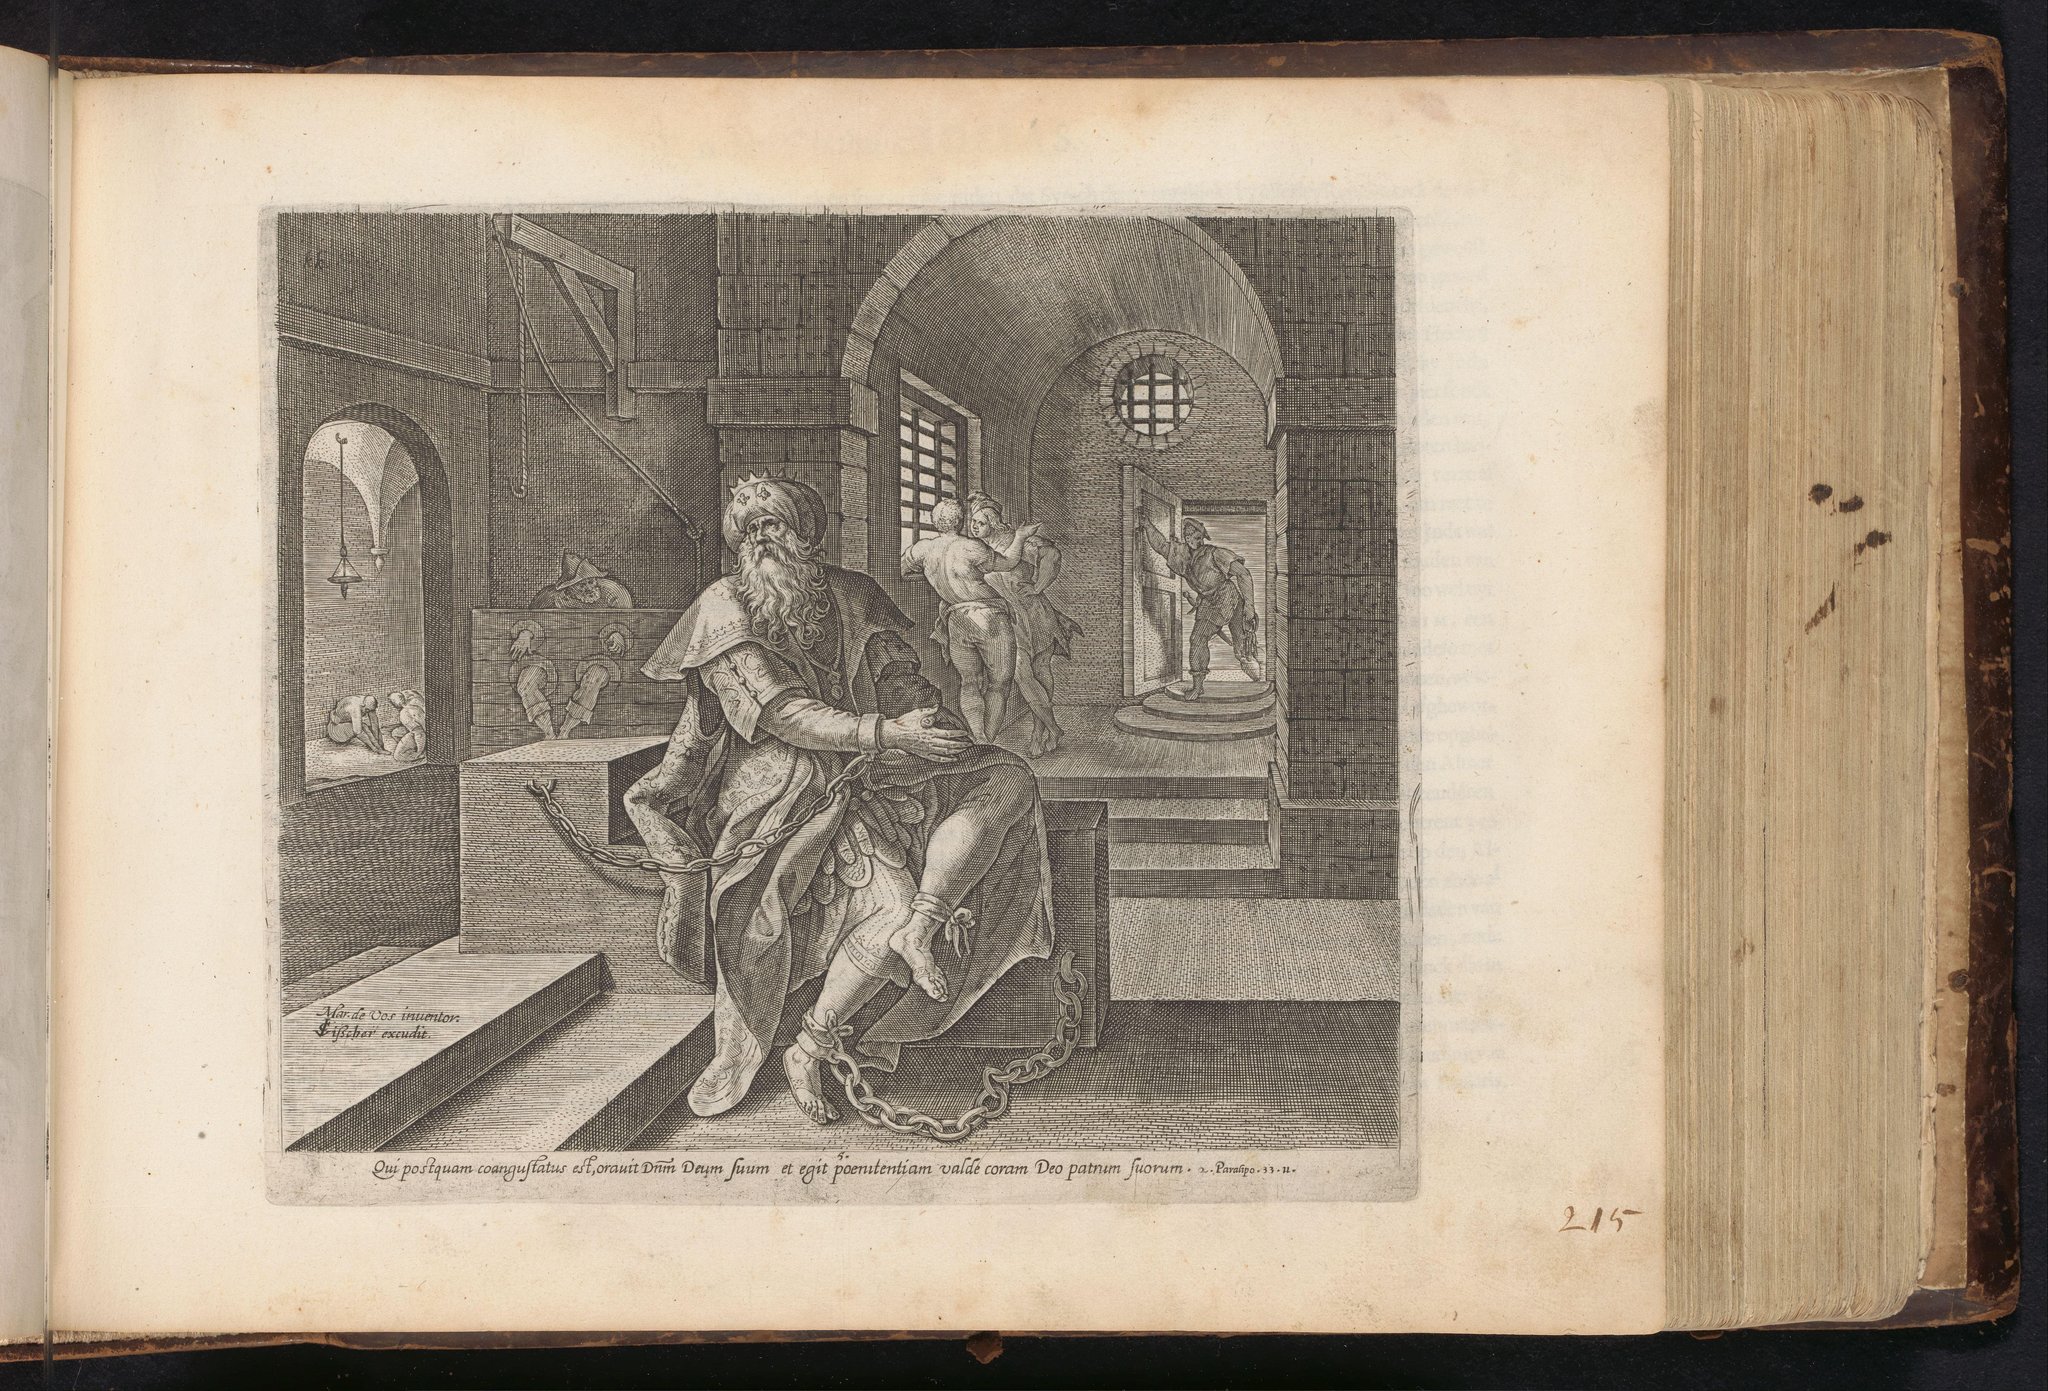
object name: print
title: Van Hiskia en Manasses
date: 1643-1646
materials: paper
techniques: engraving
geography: amsterdam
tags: the prayer of manasseh, in captivity in babylon, manasseh becomes humble and begs god for help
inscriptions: number: ‘215’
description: Koning Manasse van Juda bekeert zich in de kerkers van Babylon. Hij bidt tot God en wordt verhoord. Onder de voorstelling een verwijzing in het Latijn naar de Bijbeltekst in 2 Kron. 33:11. Deze prent maakt deel uit van een album.